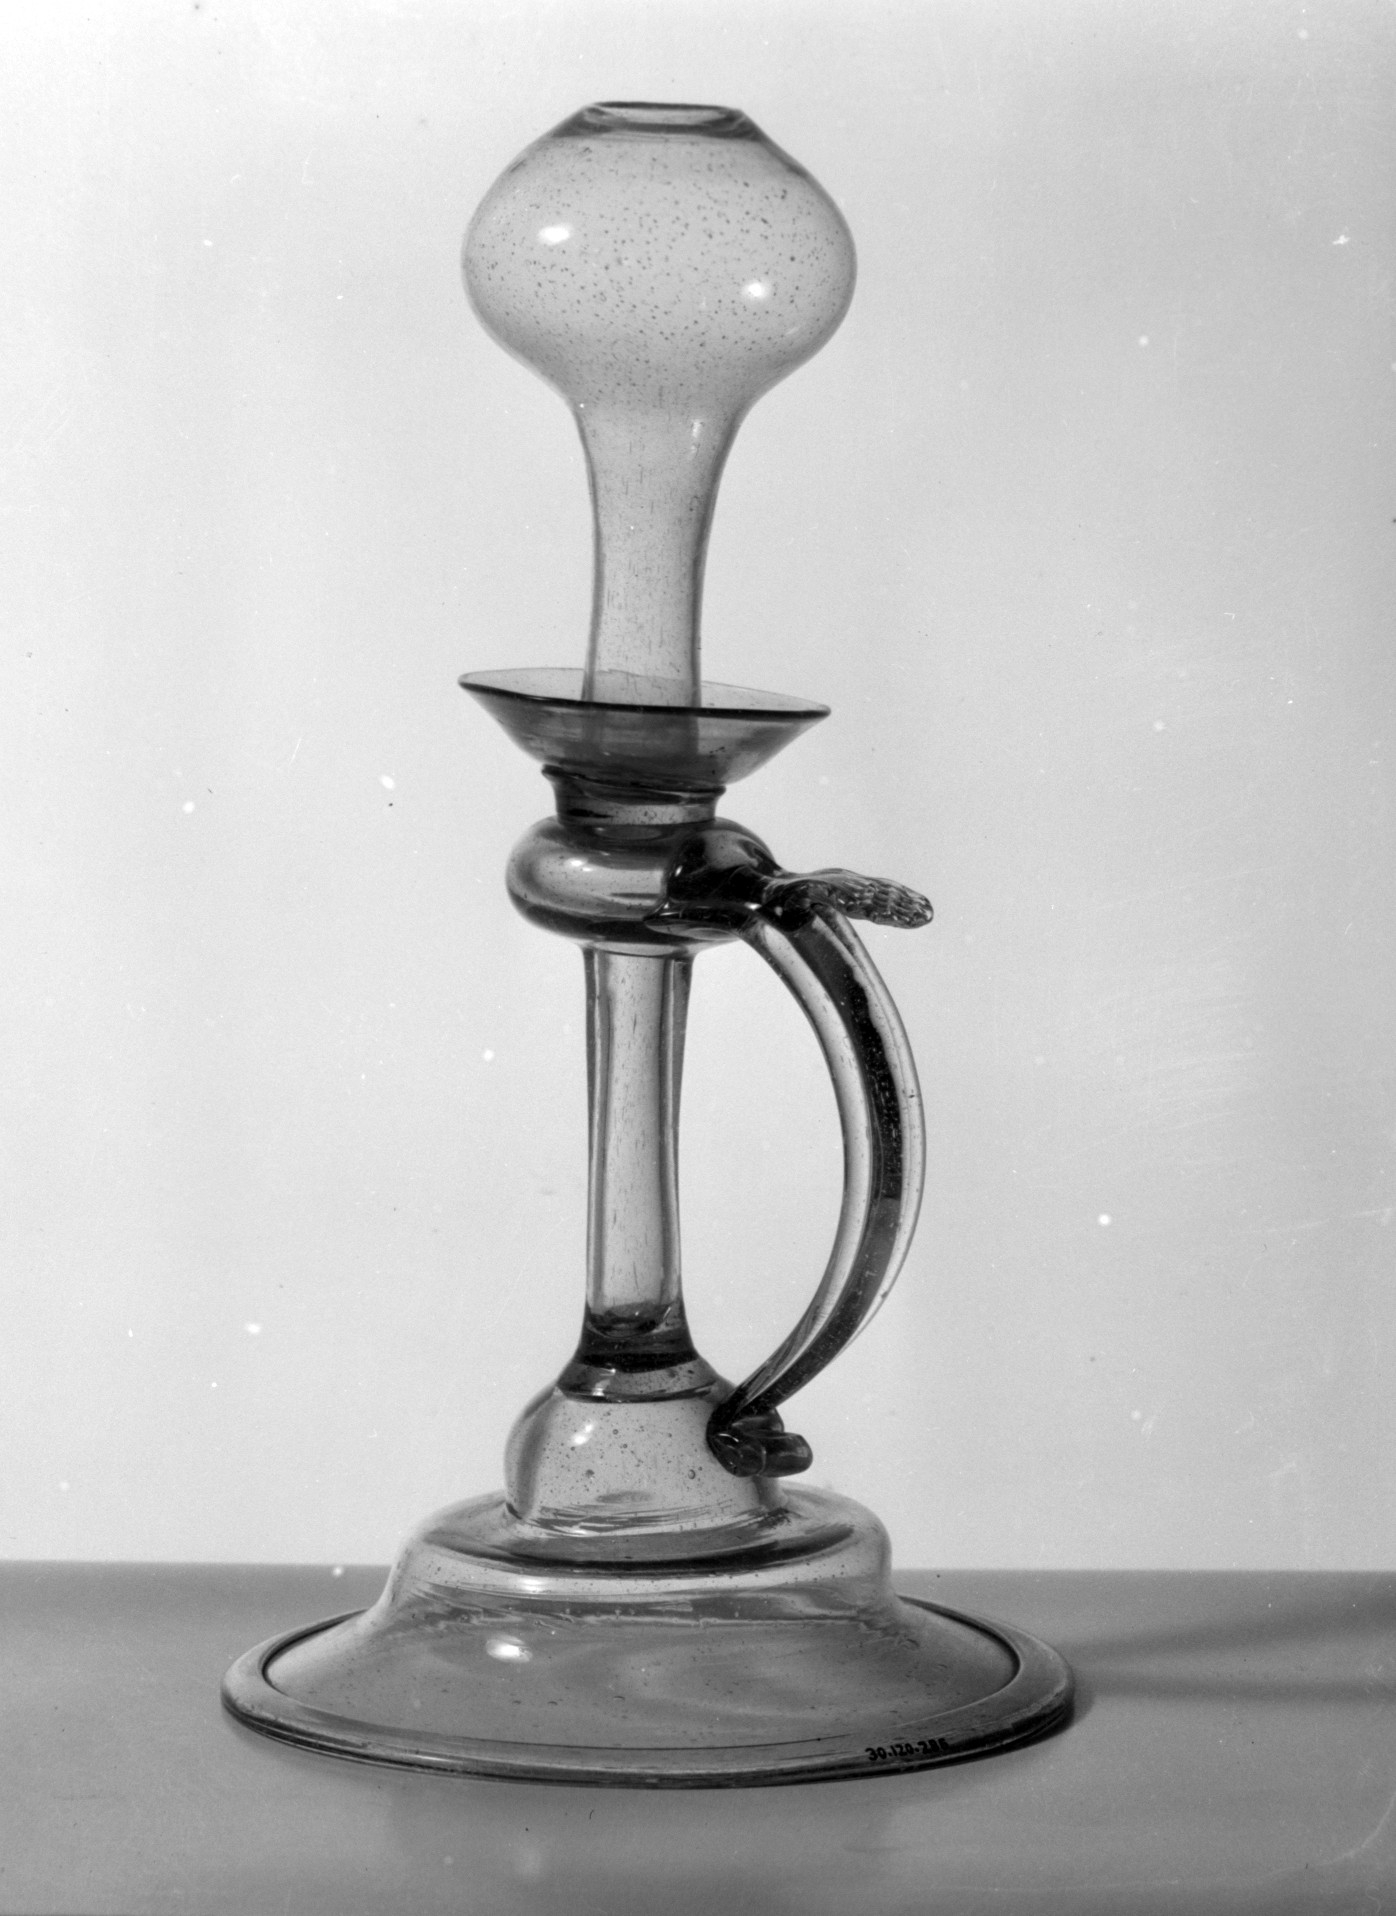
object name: lamp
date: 1701-1800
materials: glass